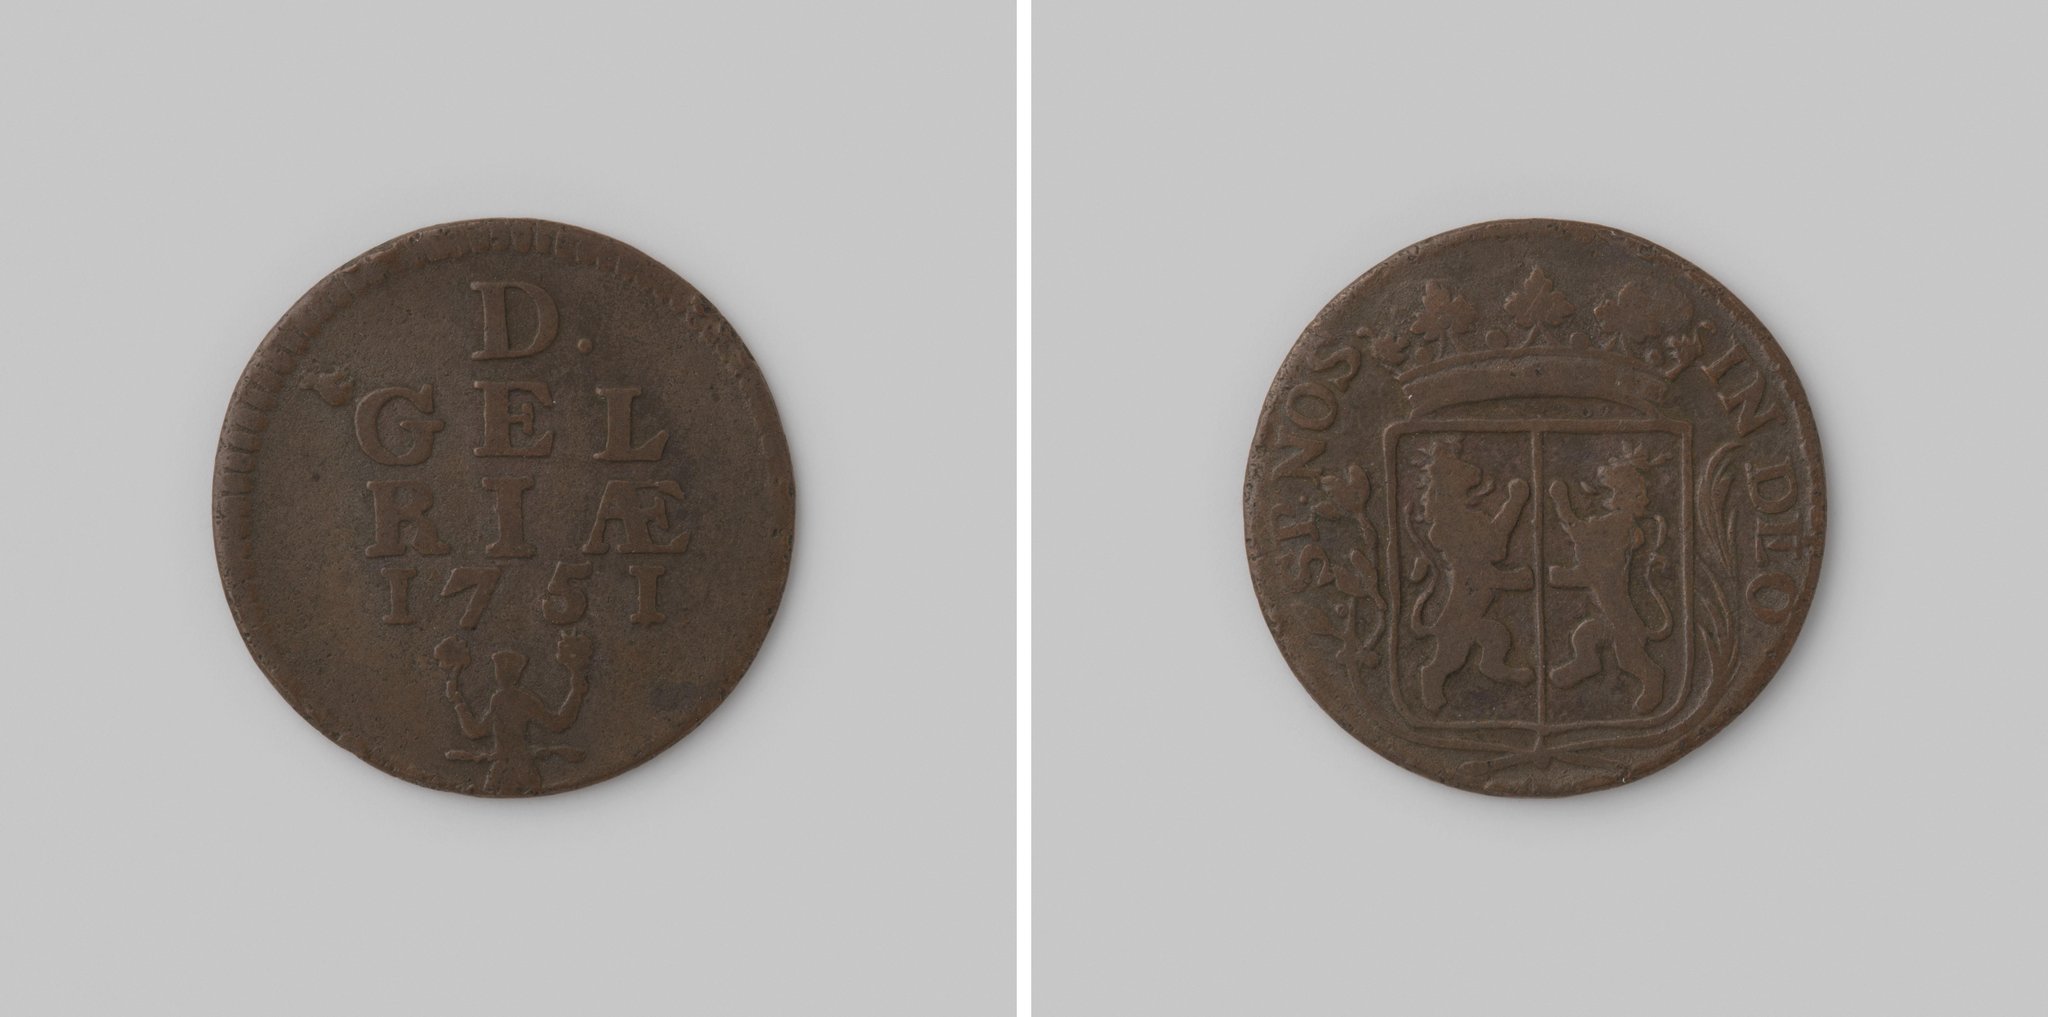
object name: coin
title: Gelderland, duit, 1751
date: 1751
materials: copper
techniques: striking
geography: harderwijk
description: Koperen munt. Voorzijde: in drie regels D/GEL/RIAE, daaronder jaartal en muntmeesterteken. Keerzijde: binnen versiering gekroond Gelders wapenschild.